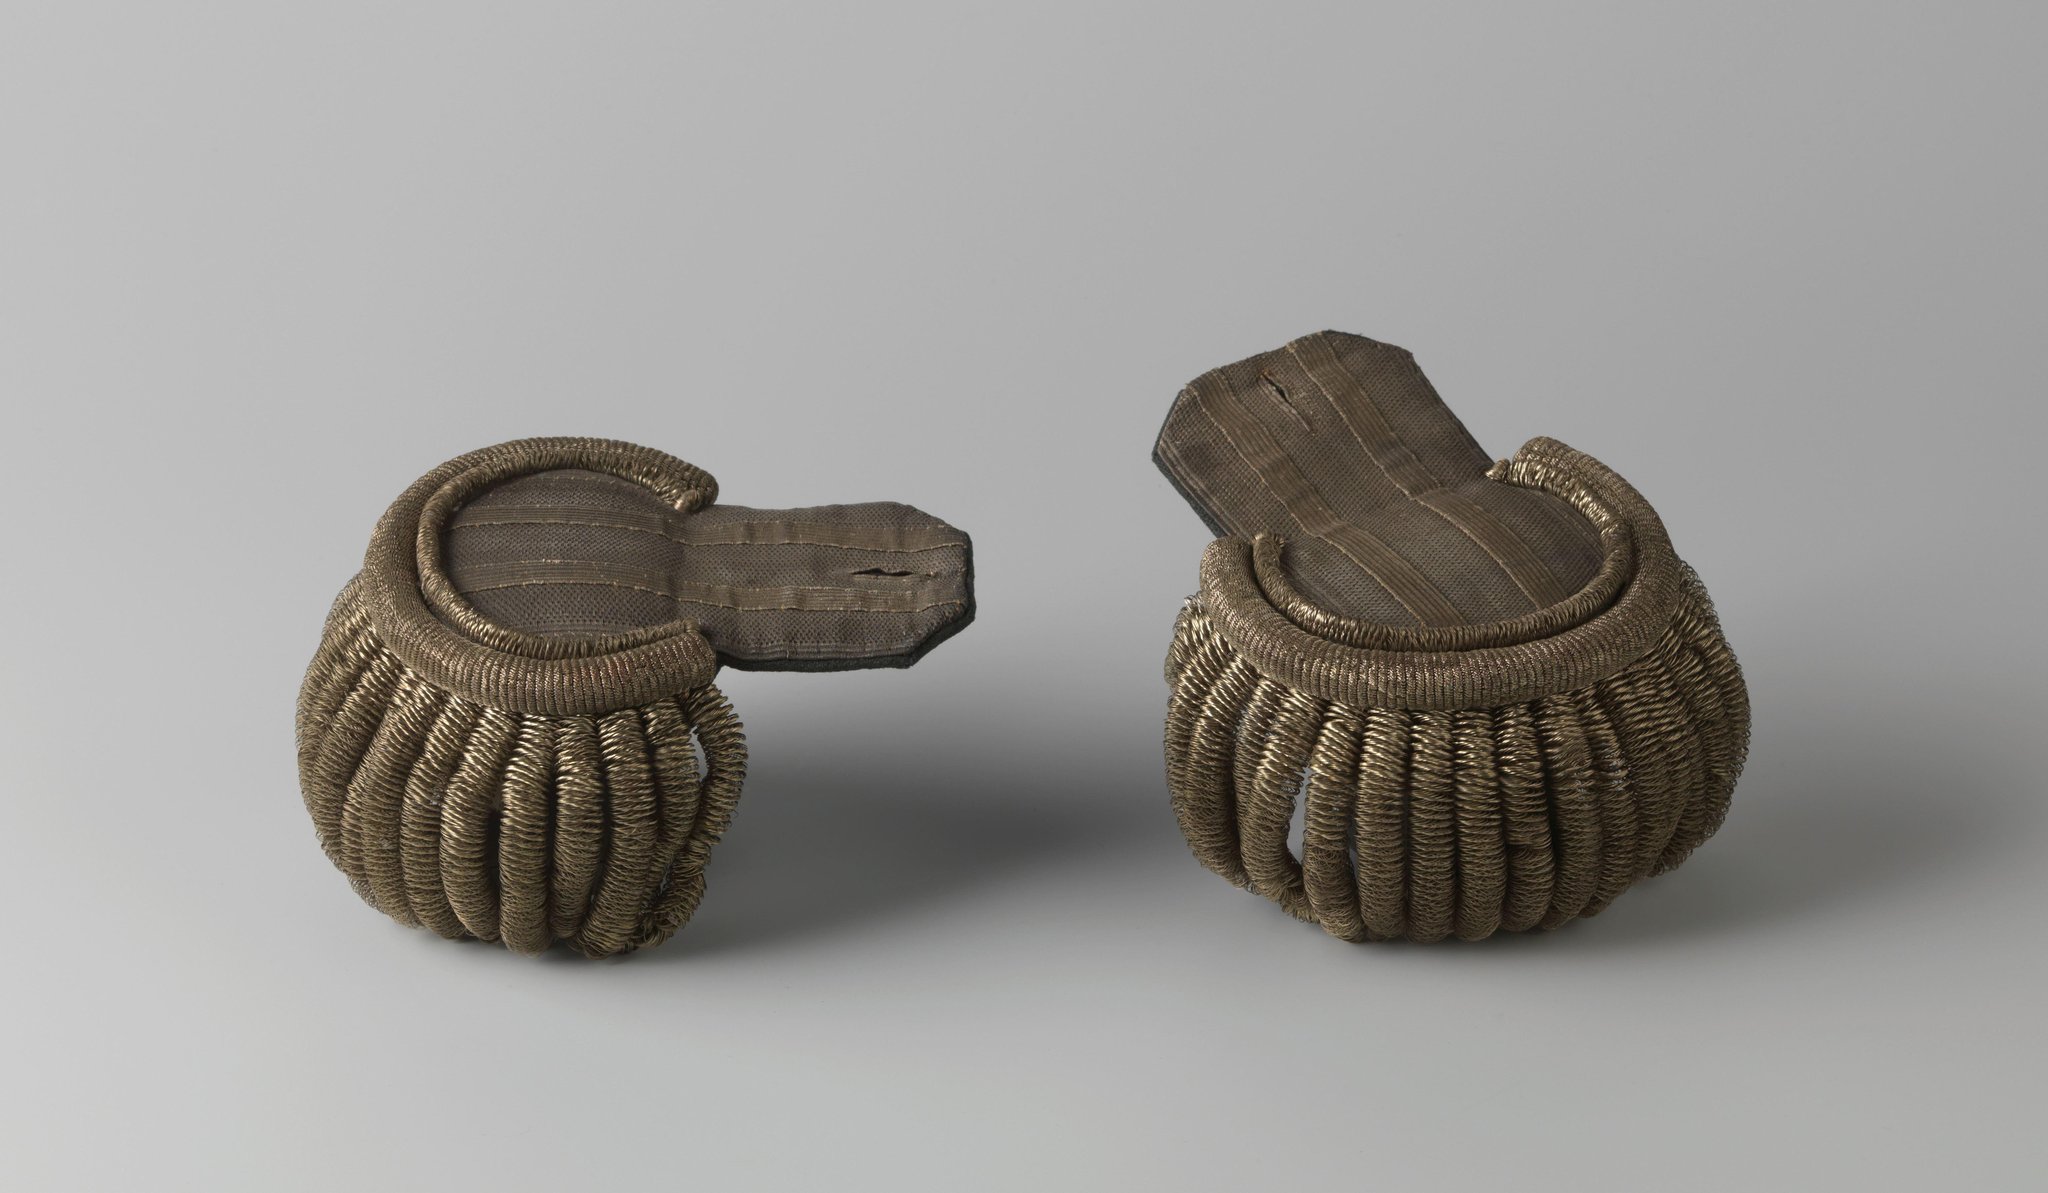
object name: epaulet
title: Epaulet van E.W. van Dam van IJsselt in 1830/32 Majoor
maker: Anonymous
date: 1800-1830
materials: thread, wool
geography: netherlands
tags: belgium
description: Een zilveren epaulet met zilveren bouillons.